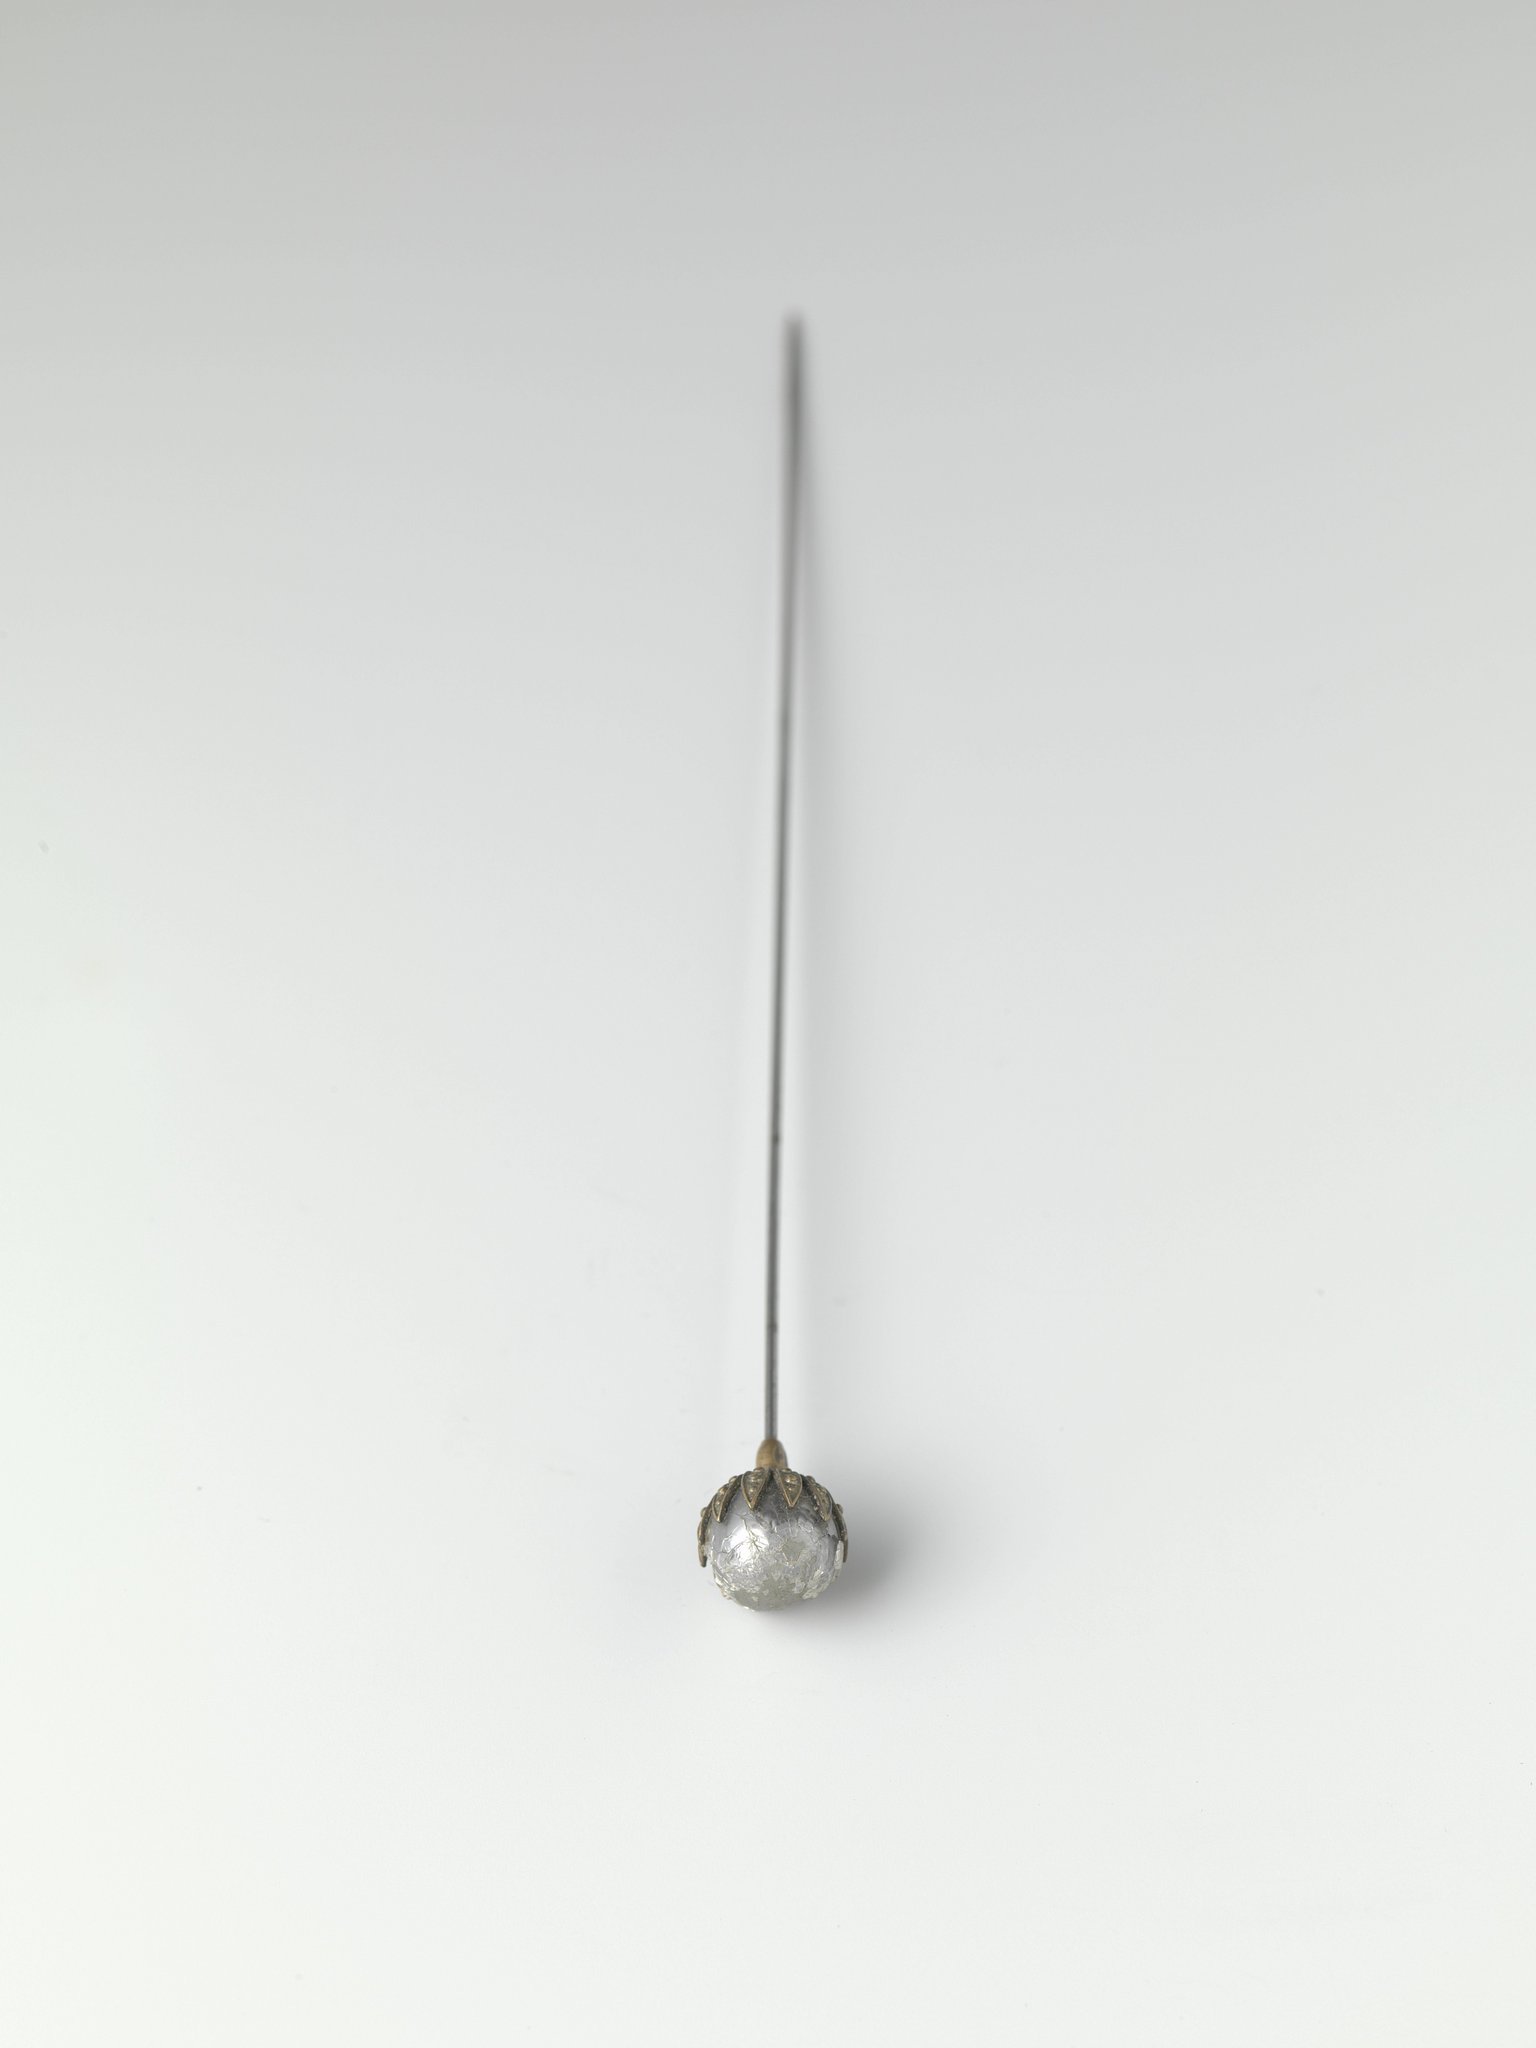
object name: hatpin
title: Hoedenspeld met knop van een kleine verzilverde bol gevat in koperen kelkblaadjes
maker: Anonymous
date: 1905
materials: copper, glass, steel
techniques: manufacturing, forging, silvering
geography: netherlands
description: Hoedenspeld met kleine verzilverde bol gevat in puntige koperen kelkblaadjes.